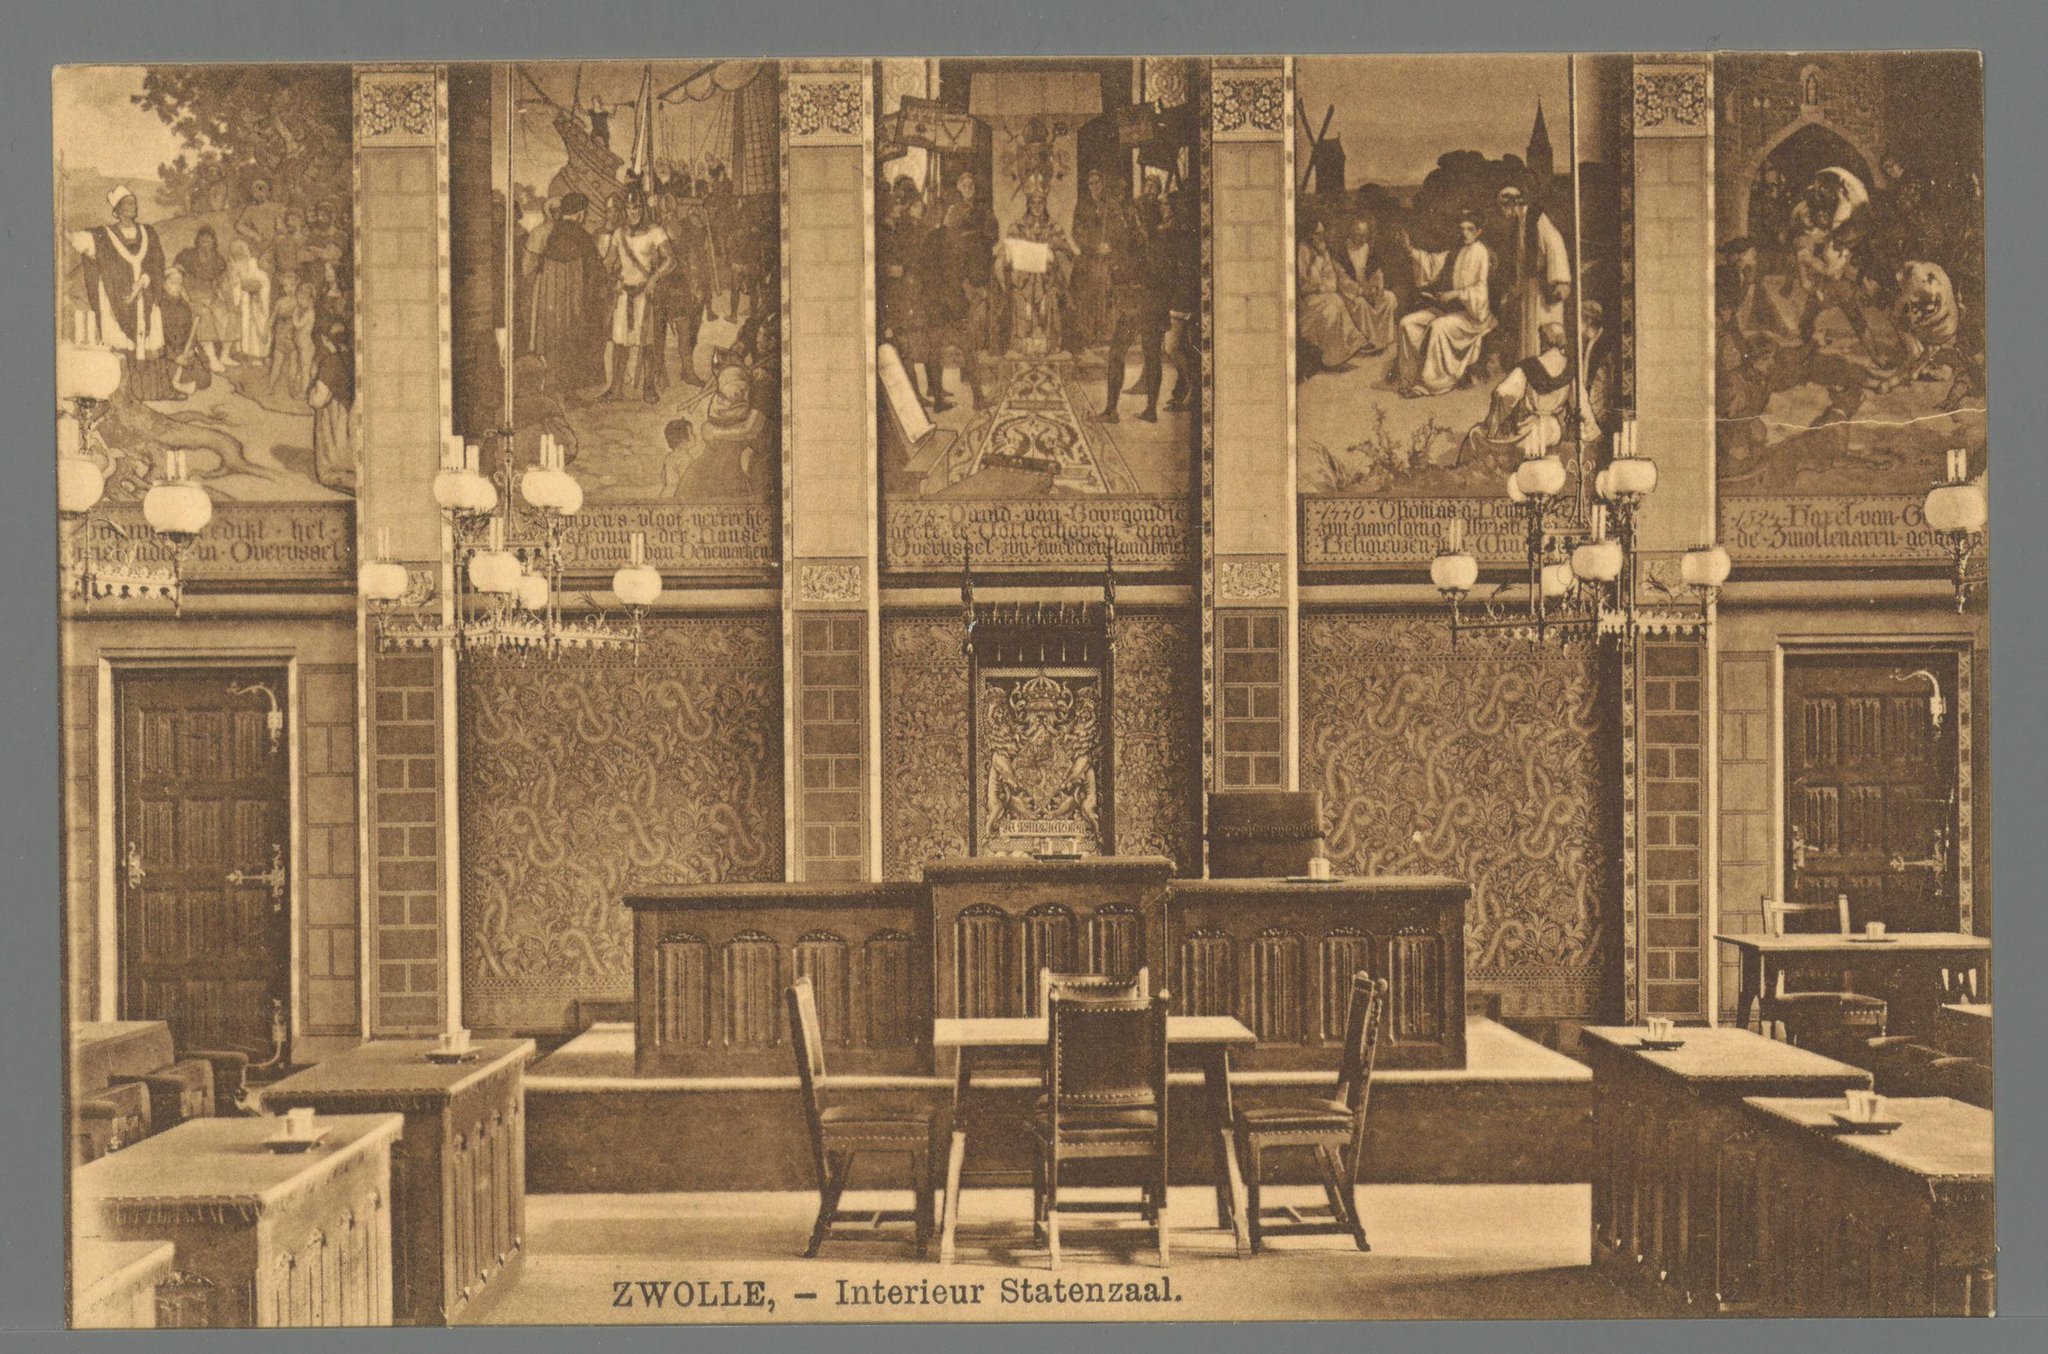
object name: photomechanical print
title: Zwolle, - Interieur Statenzaal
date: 1905-1927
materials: cardboard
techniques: photograph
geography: velsen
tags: interior of the house